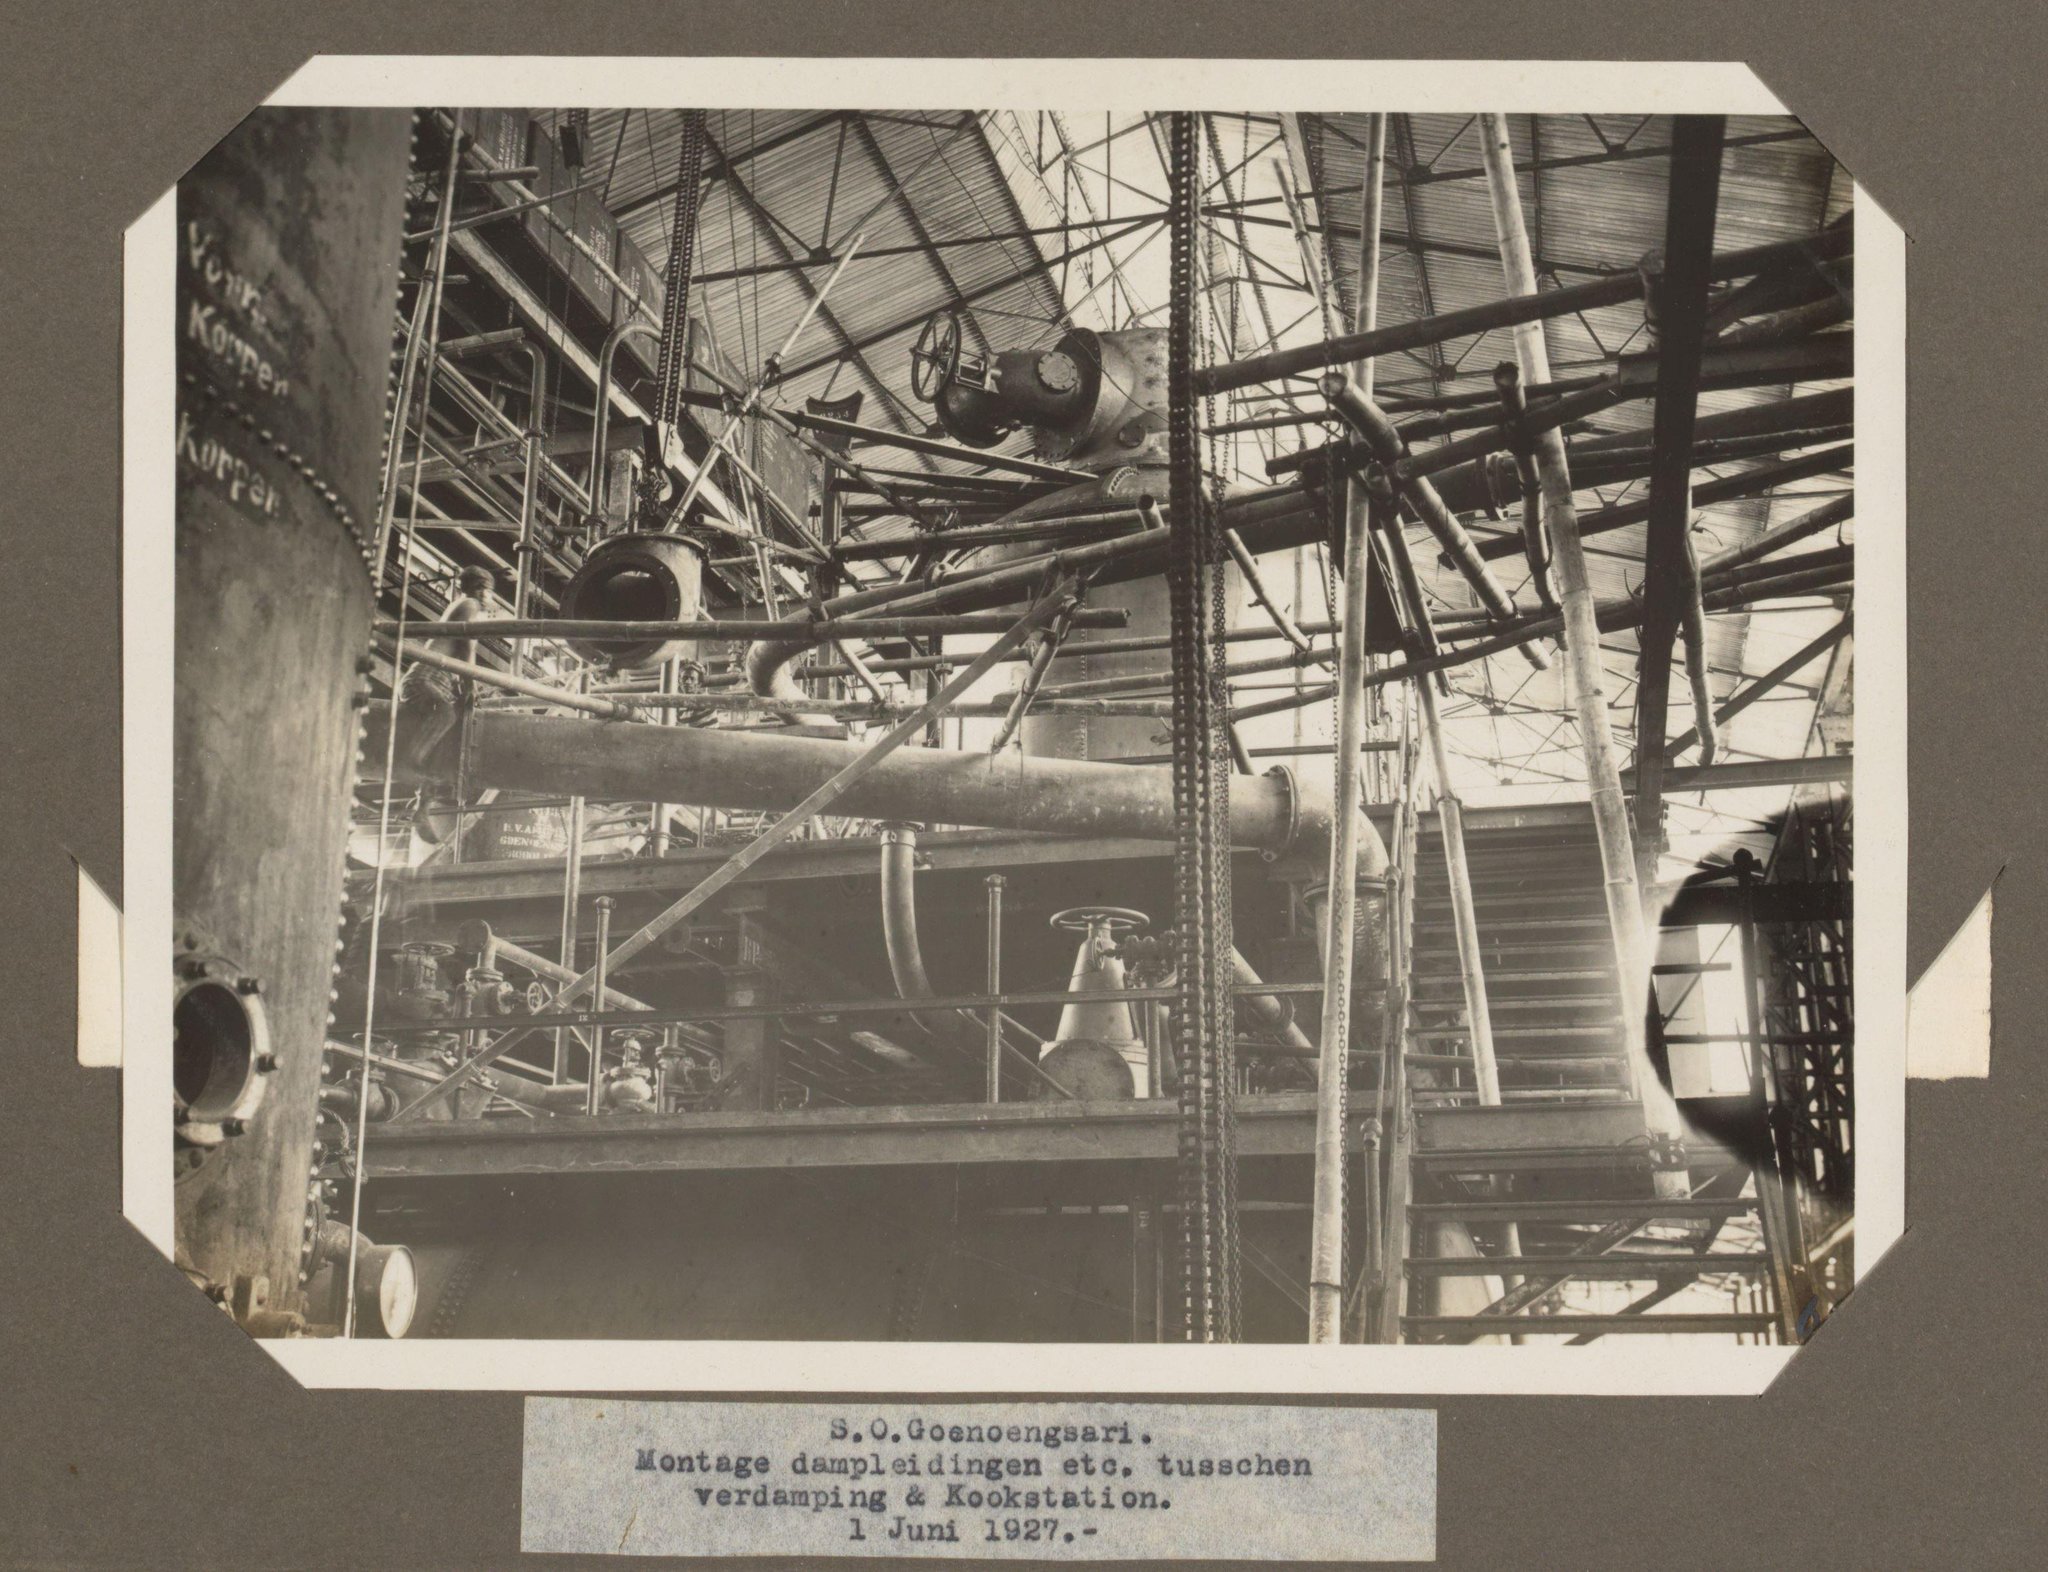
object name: photograph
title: S.O. Goenoengsari. Montage dampleidingen etc. tusschen Verdamping & Kookstation. 1 Juni 1927.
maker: Anonymous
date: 1906-1927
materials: photographic support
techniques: gelatin silver print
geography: east java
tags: colonial system, trade-company, factory-interior, machine shop, making the overground structures (~ building activities), (non-fruit) products of plants or trees: sugarcane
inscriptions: inscription: ‘S.O. Goenoengsari. Montage dampleidingen etc. tusschen Verdamping & Kookstation. 1 Juni 1927.’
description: Interieur van een fabrieksgebouw in aanbouw met netwerk van buizen en leidingen, juni 1927. Onderdeel van het fotoalbum met foto's van de opbouw van de suikerfabriek te Goenoengsari op Oost-Java door de Handels Vereniging Amsterdam 1926-1927.